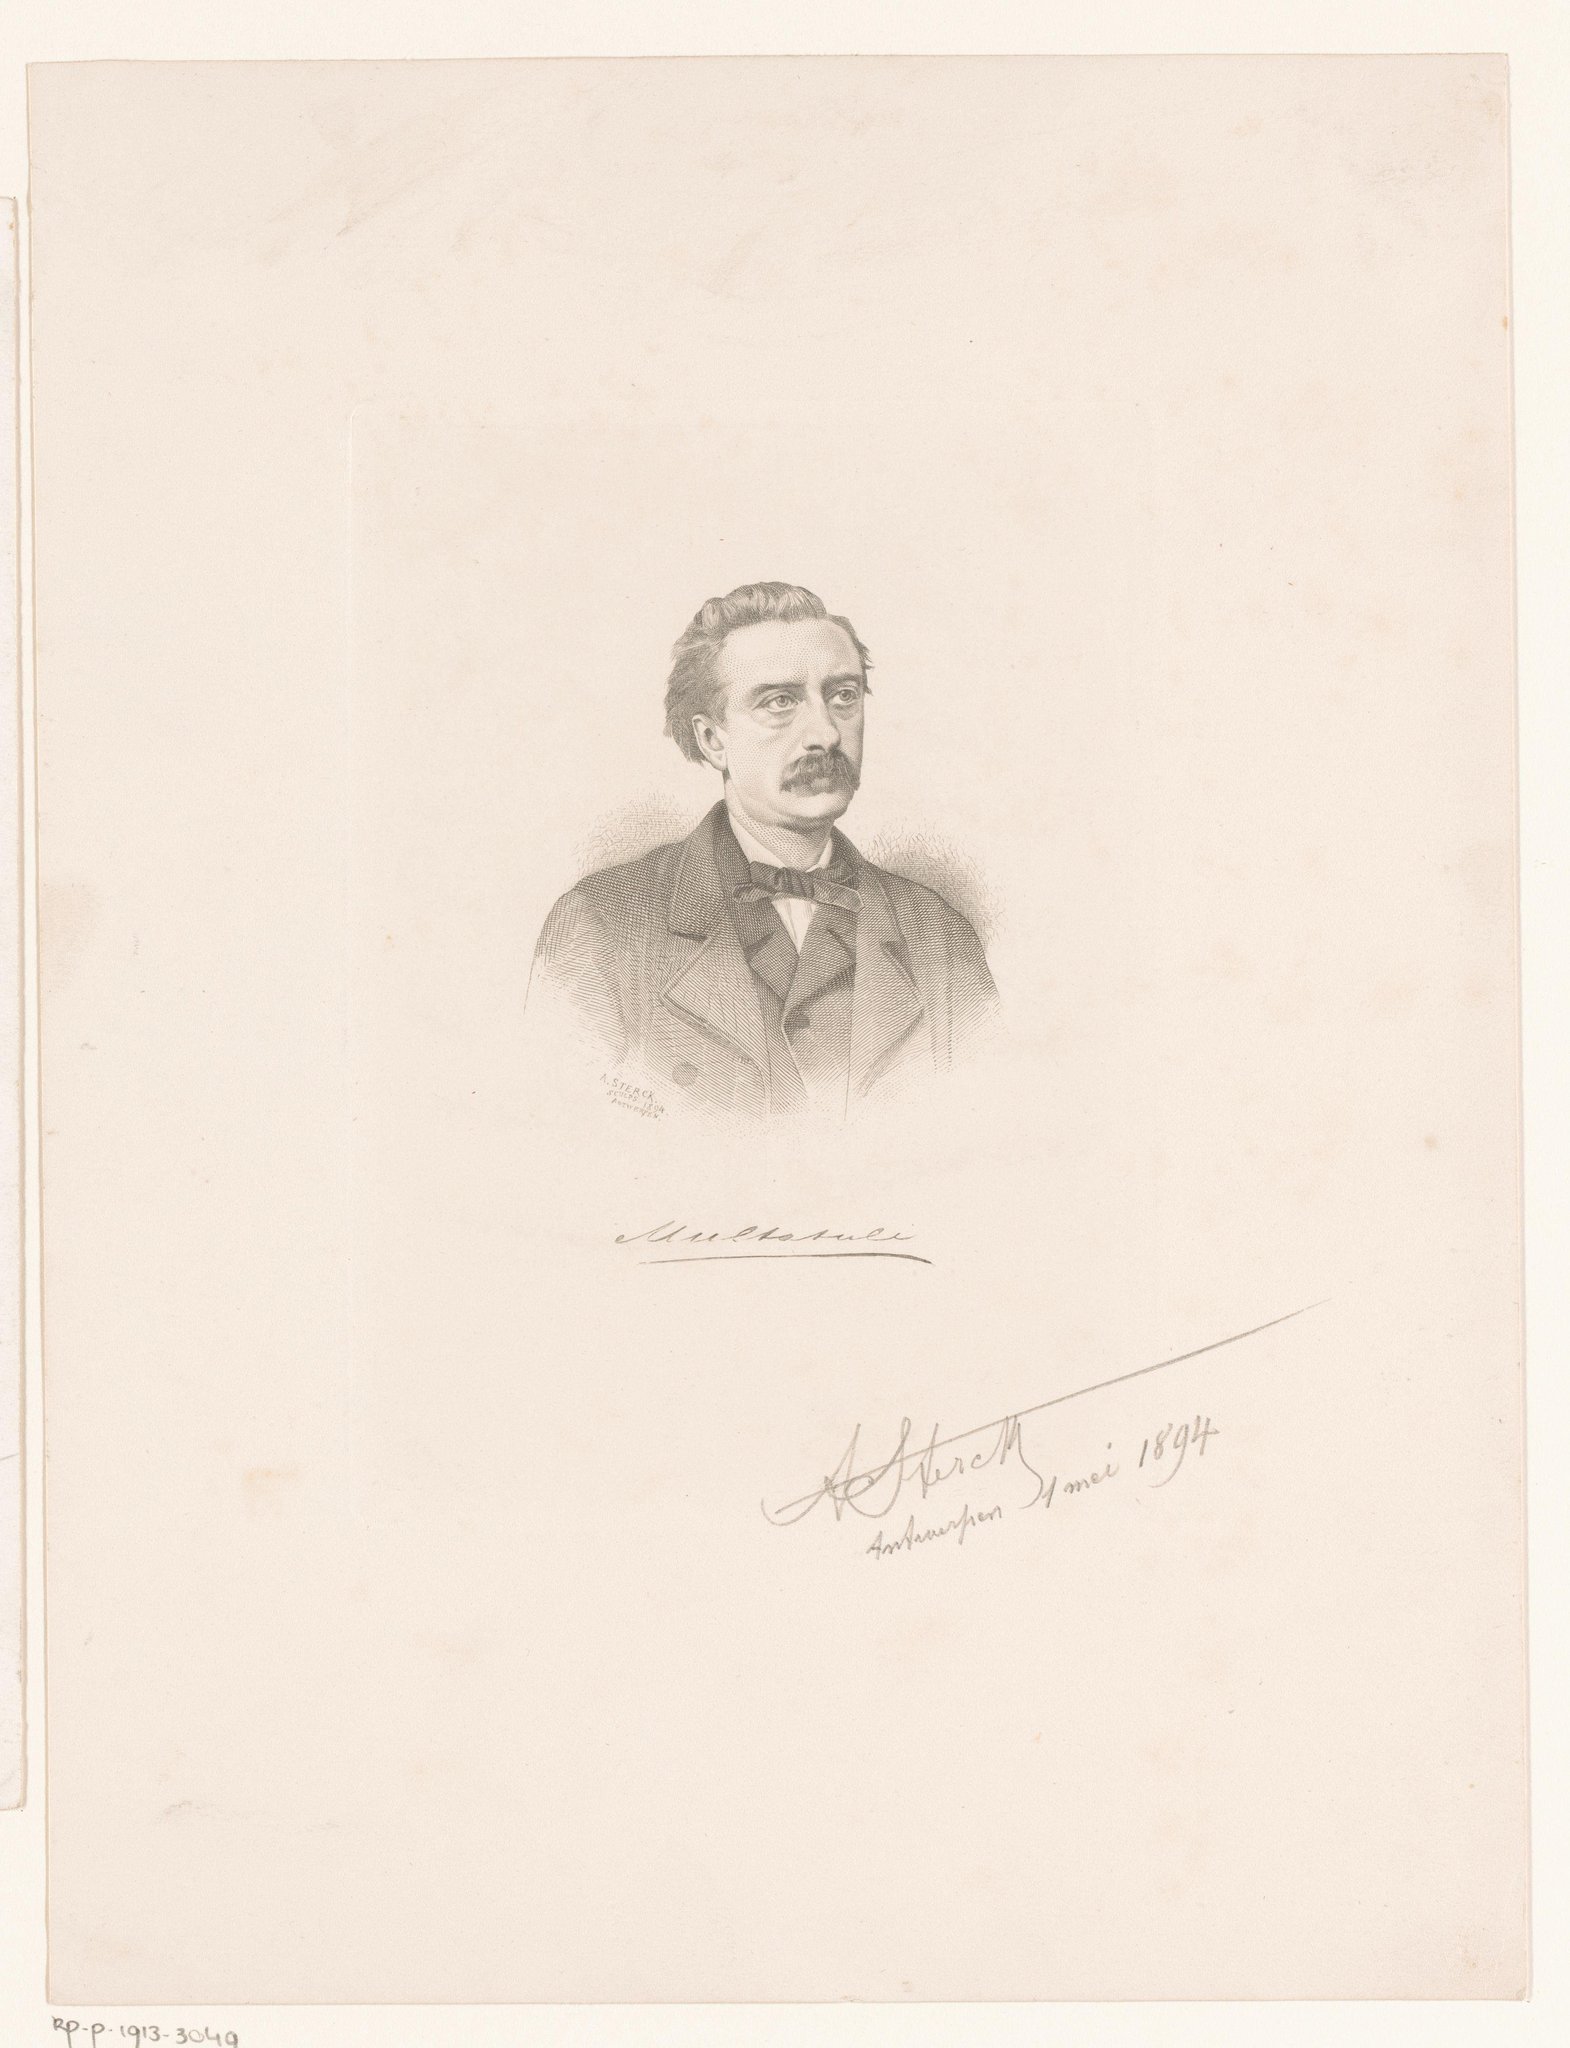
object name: print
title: Portret van Multatuli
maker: arthur sterck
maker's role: print maker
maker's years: 1868-1897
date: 1894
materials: paper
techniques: etching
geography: antwerp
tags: amsterdam, multatuli, historical persons, portrait of a writer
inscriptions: collector's mark: Lugt 2228